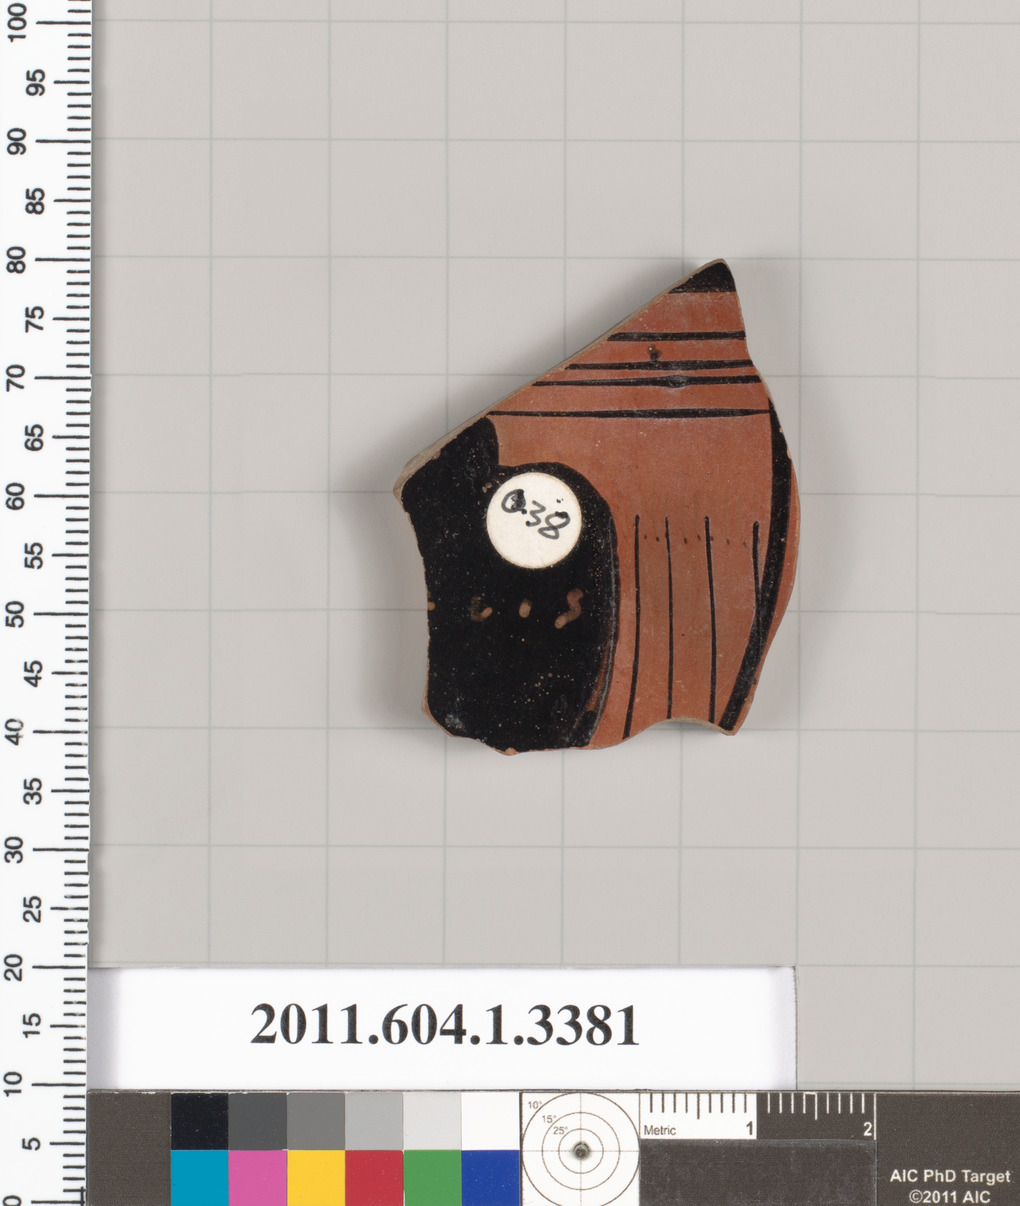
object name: kylix fragment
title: Terracotta fragment of a kylix (drinking cup)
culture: greek, attic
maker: tarquinia painter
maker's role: artist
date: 470-460 BCE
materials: terracotta